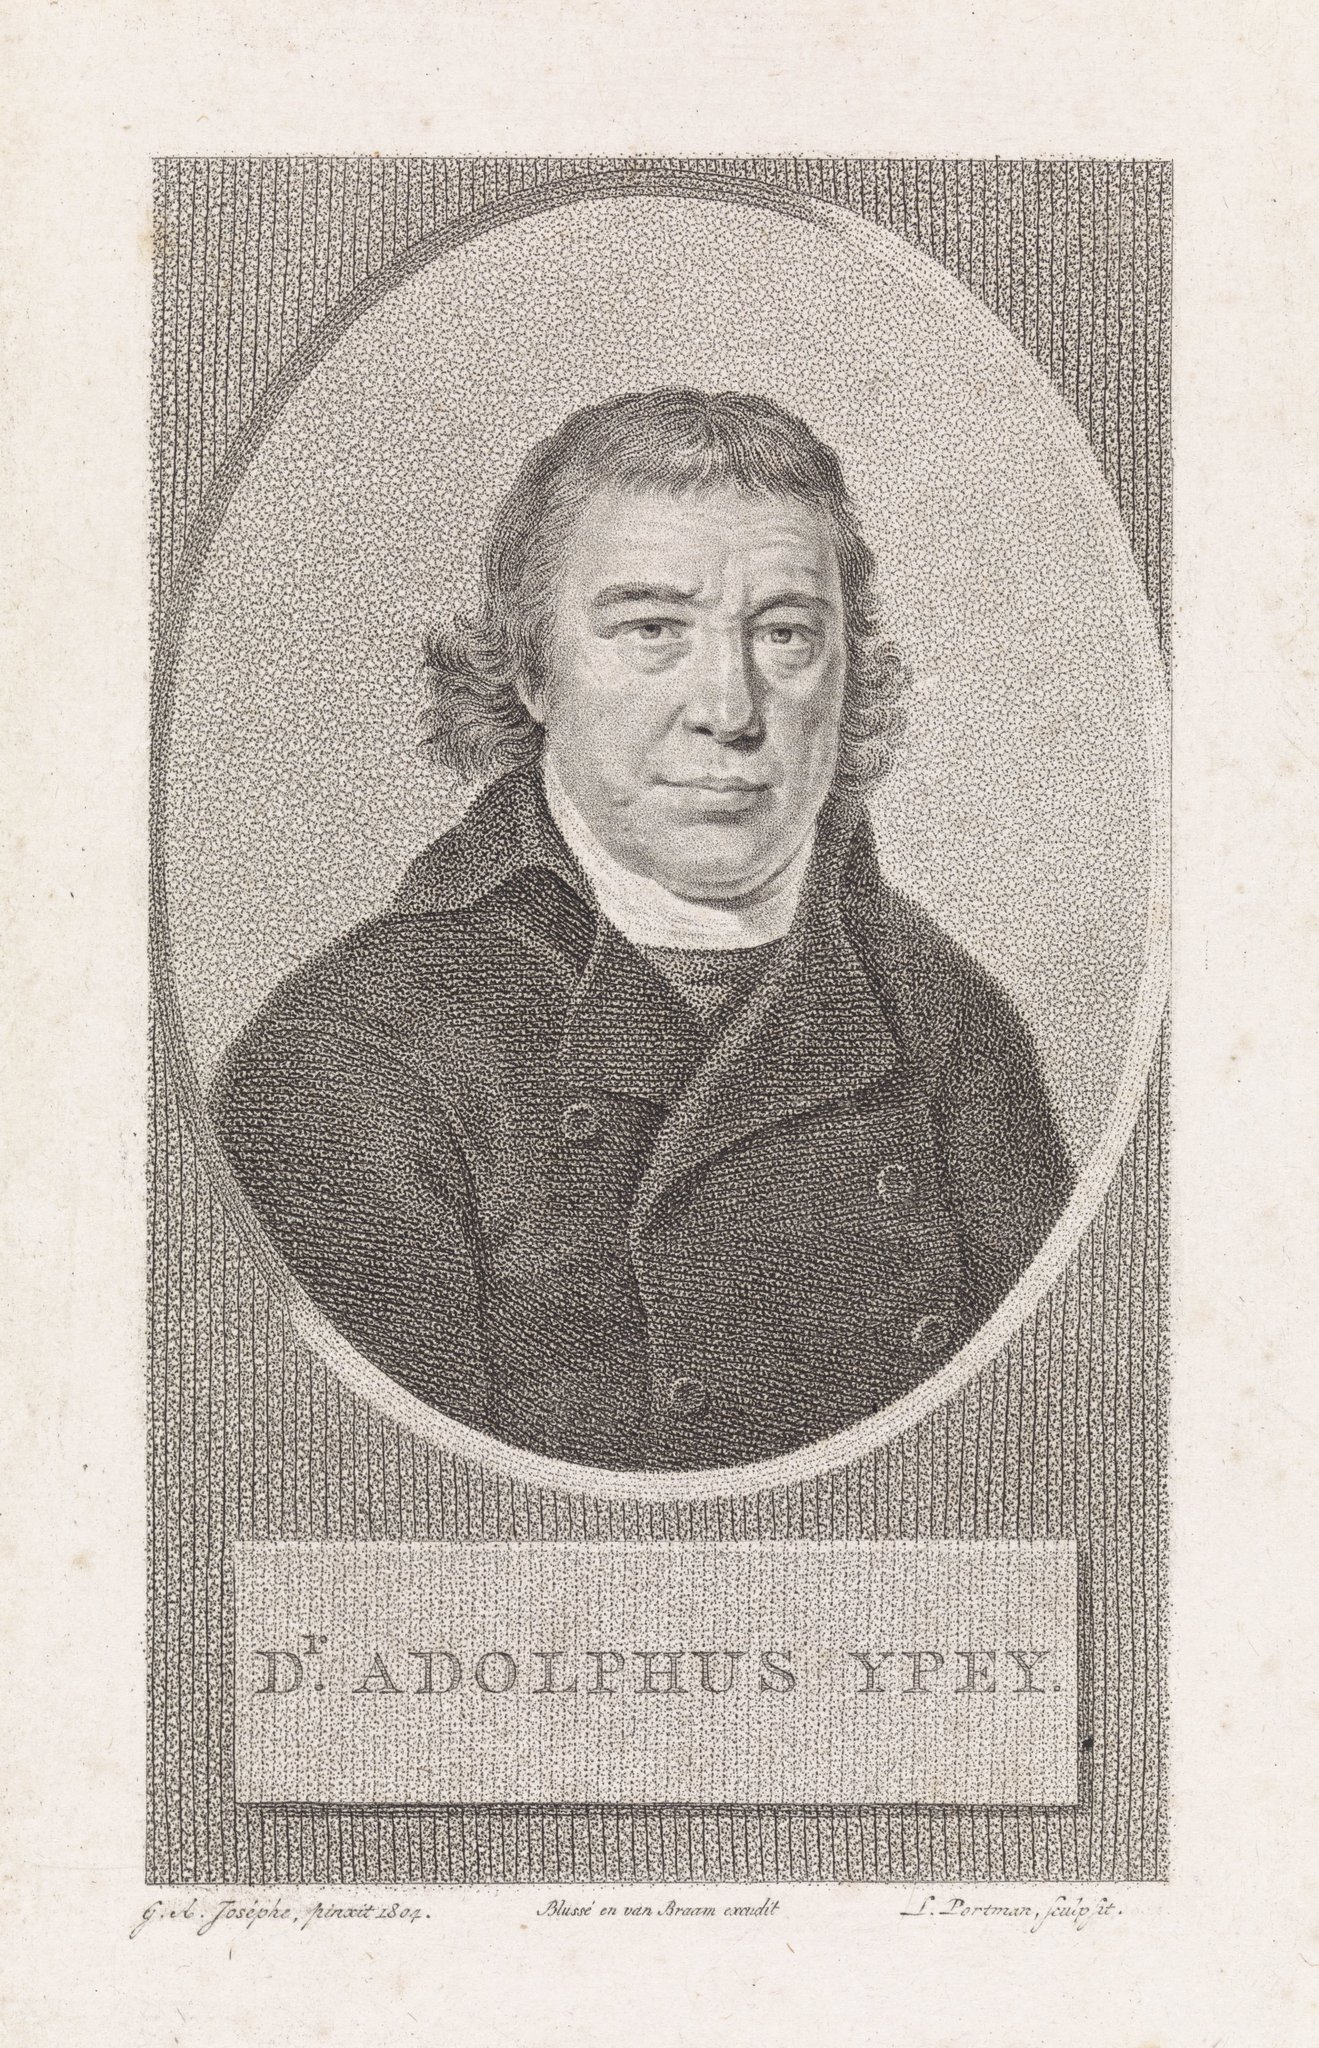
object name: print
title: Portret van de rechtsgeleerde Adolph Ypeij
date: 1804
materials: paper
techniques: etching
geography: amsterdam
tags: leeuwarden, rechtsgeleerde, adolph ypeij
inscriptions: collector's mark: Lugt 2228